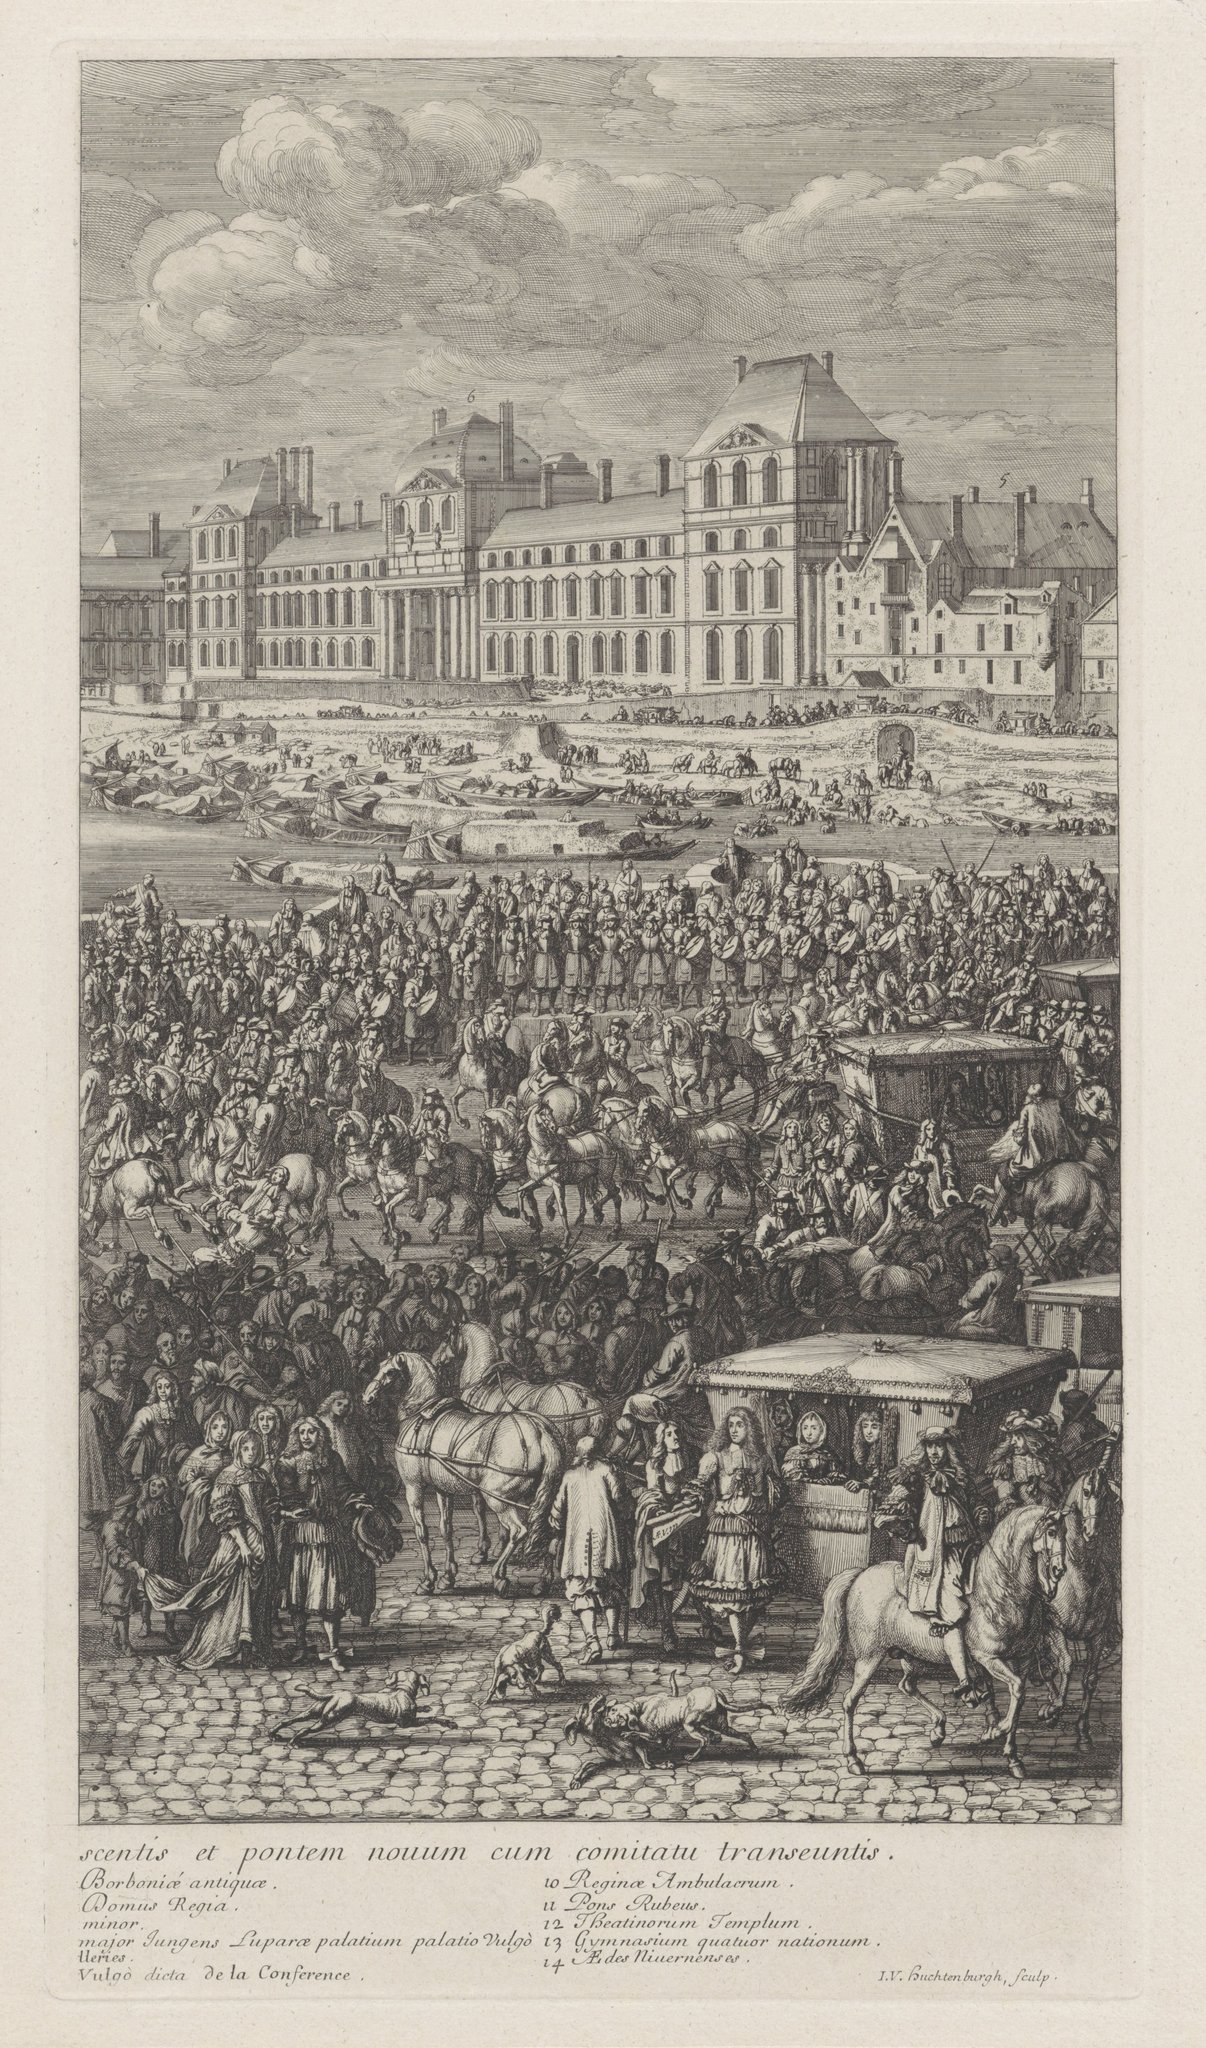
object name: print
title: Marche du Roy accompagné de ses gardes (...)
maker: jan van huchtenburg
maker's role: draughtsman, painter, print maker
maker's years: 1647-1733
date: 1667-1669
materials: paper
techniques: engraving, etching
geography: paris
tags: river, royal household; courtiers, retinue, train, bridge, four-wheeled vehicle drawn by more than three animals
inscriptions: collector's mark: Lugt 2228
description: De achterhoede van de koninklijke stoet van Lodewijk XIV, koning van Frankrijk op Pont-Neuf in Parijs. Op de voorgrond staat een koets stil en kijken mensen naar vechtende honden. Op de achtergrond de rivier de Seine. Onderaan in de marge een deel van de legenda in het Frans en het Latijn.